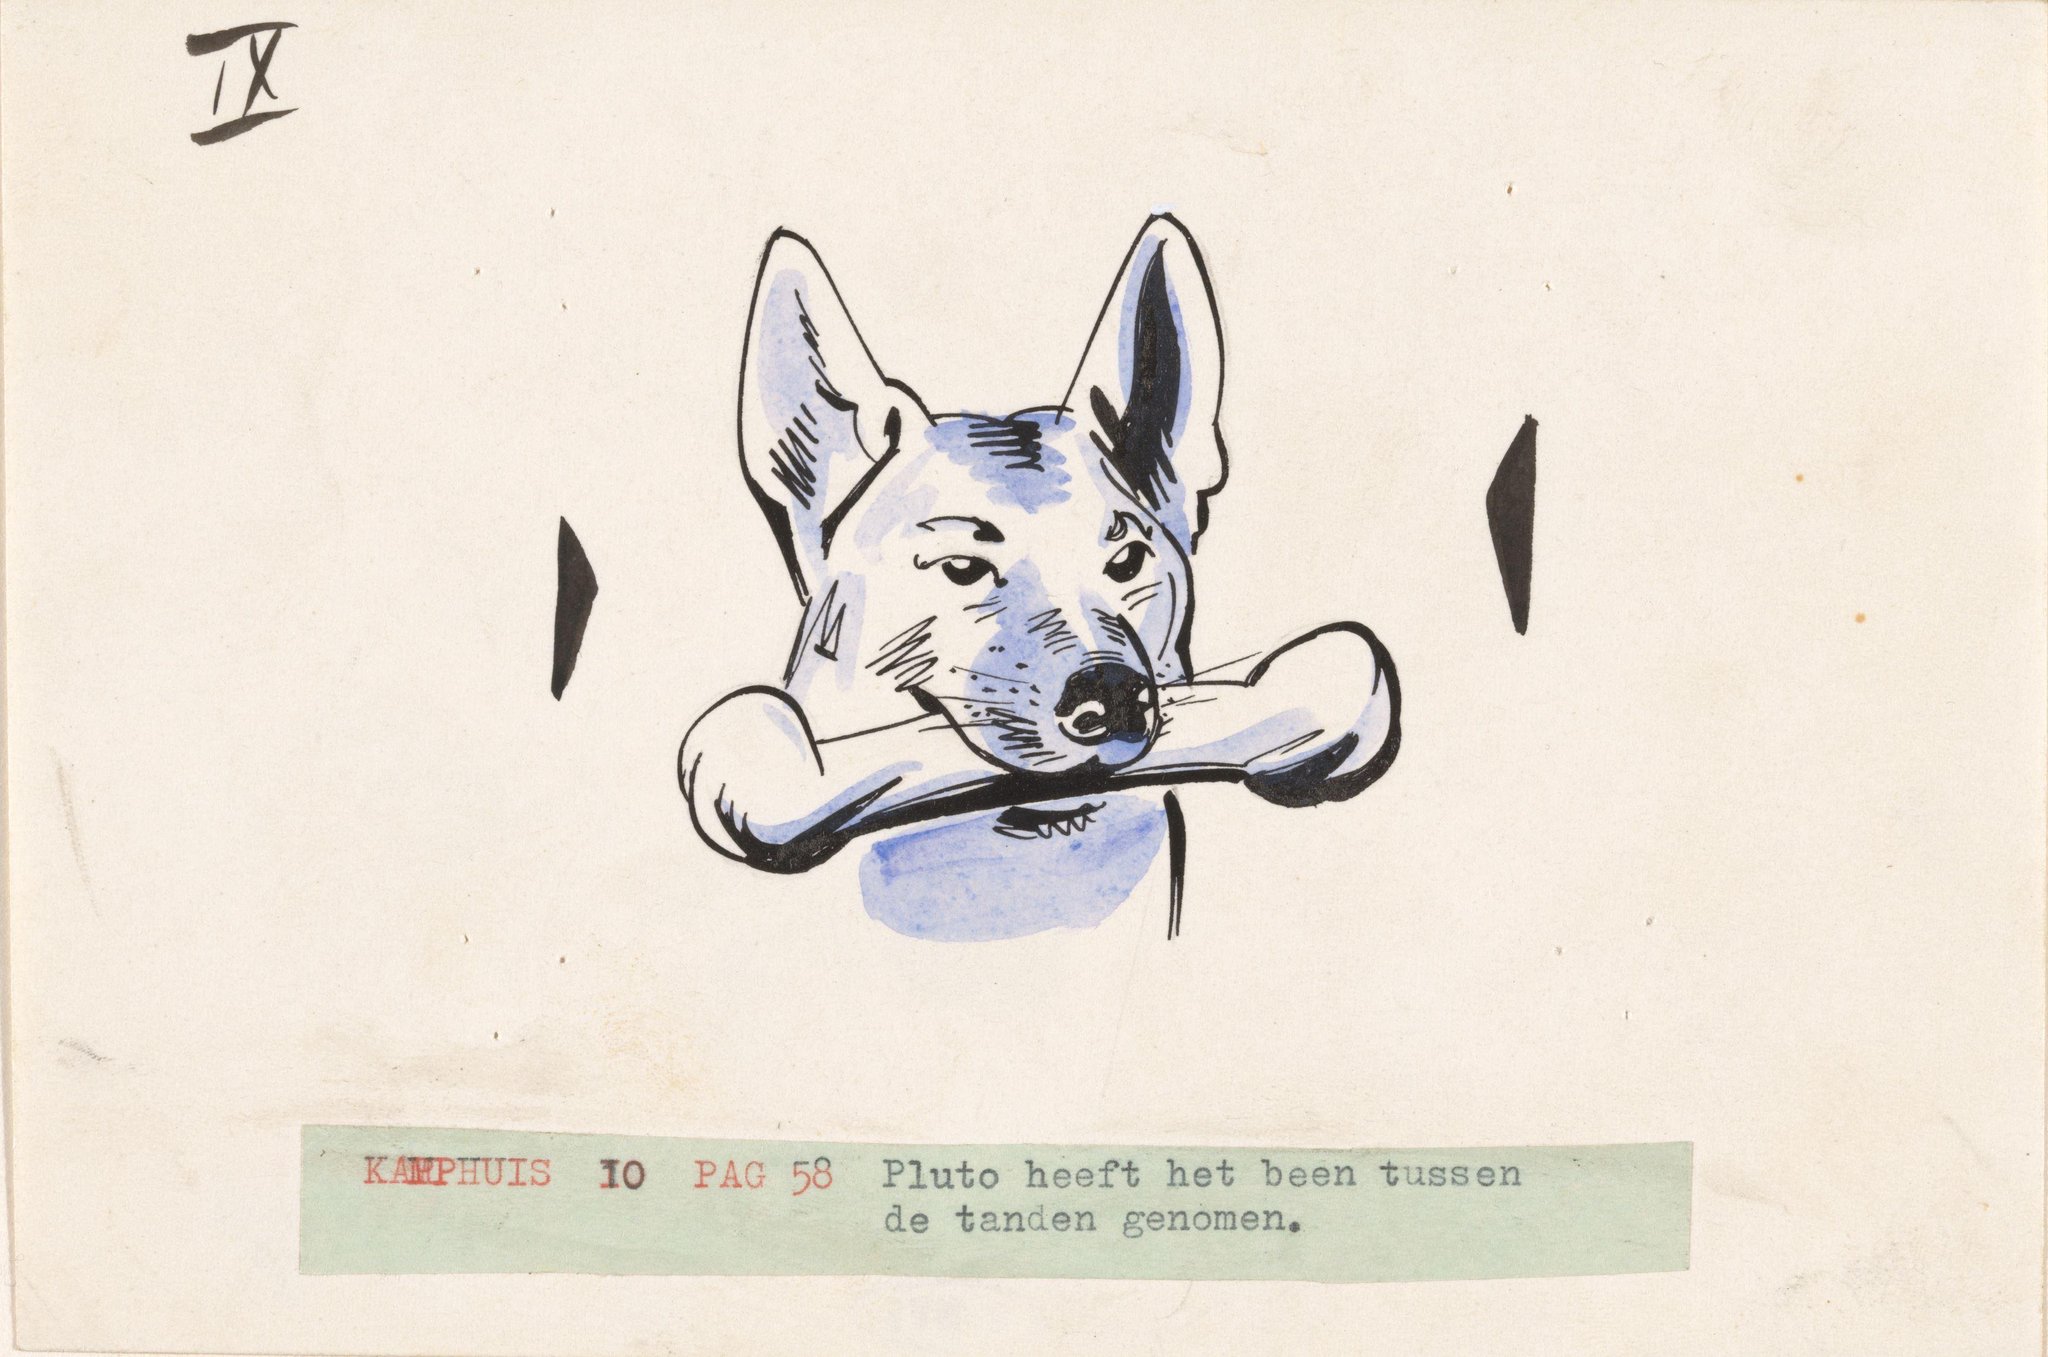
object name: drawing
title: Hond Pluto met een bot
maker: hans borrebach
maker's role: draughtsman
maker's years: 1903-1991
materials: ink, paper, pencil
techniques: brush, pen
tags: dog with bone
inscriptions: annotation: ‘KAMPHUIS 10 pag 58 Pluto heeft het been tussen/ de tanden genomen.’, collector's mark: Lugt 2228a, :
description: Ontwerp voor: Baljé, J.P. Het kamphuis in de duinen. Amsterdam: Veen, 1953.